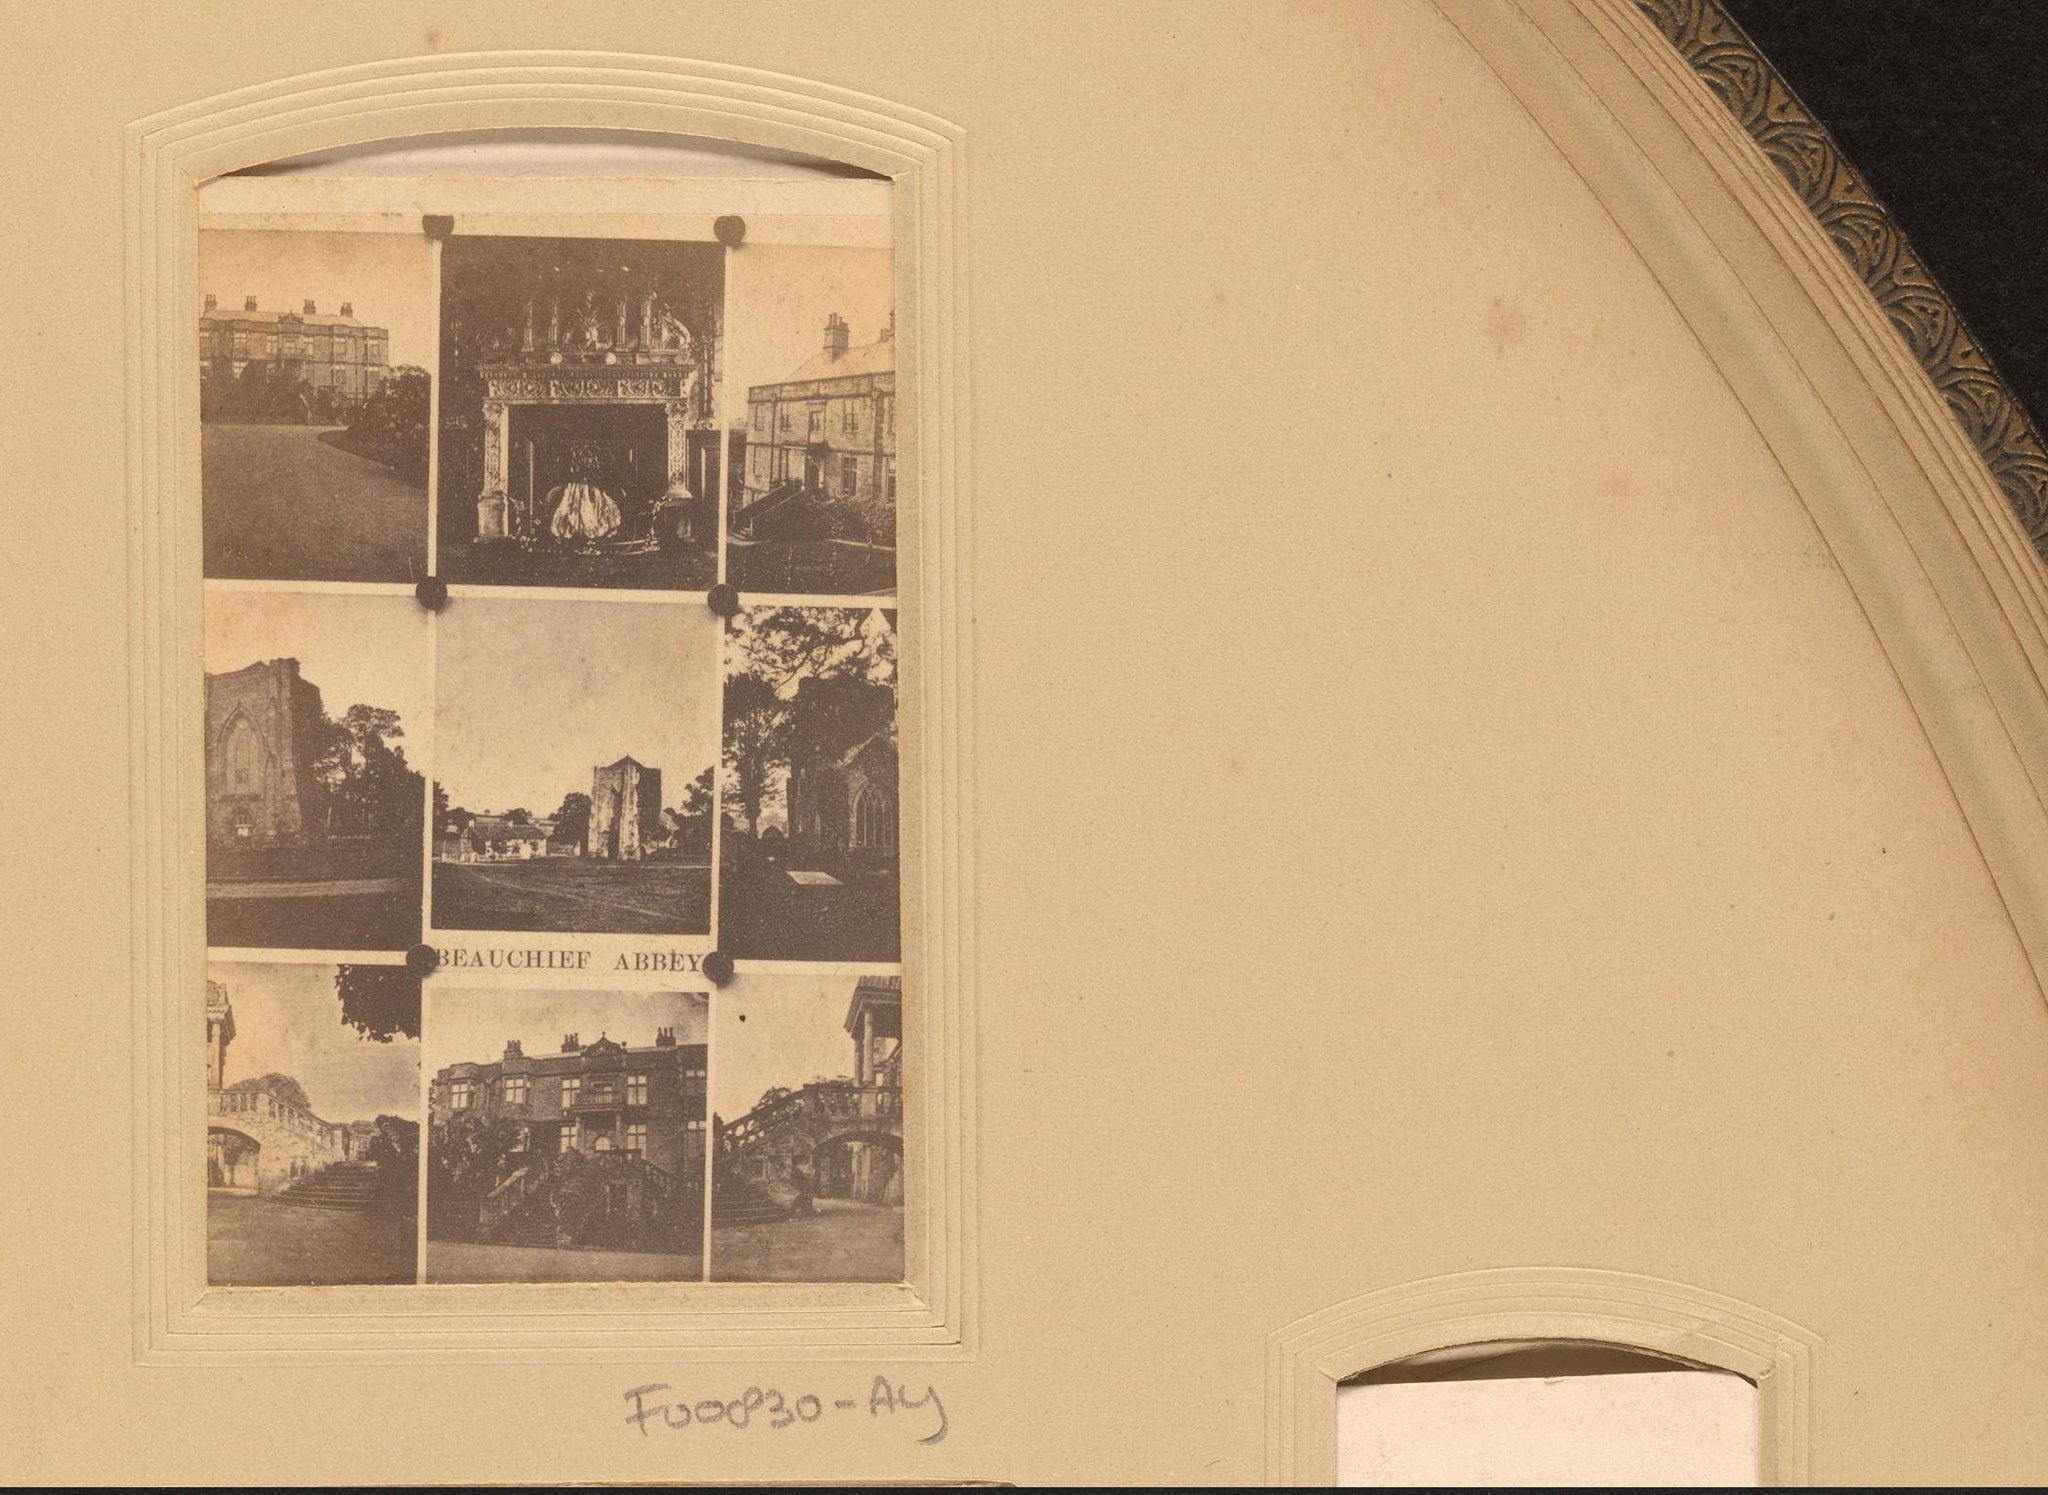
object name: photograph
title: Negen gebouwen waaronder Beauchief Abbey te Sheffield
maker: Anonymous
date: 1870-1910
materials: cardboard, photographic support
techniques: albumen print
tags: abbey, monastery, convent ~ roman catholic church, civic architecture; edifices; dwellings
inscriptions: annotation: ‘Williams CSQ’